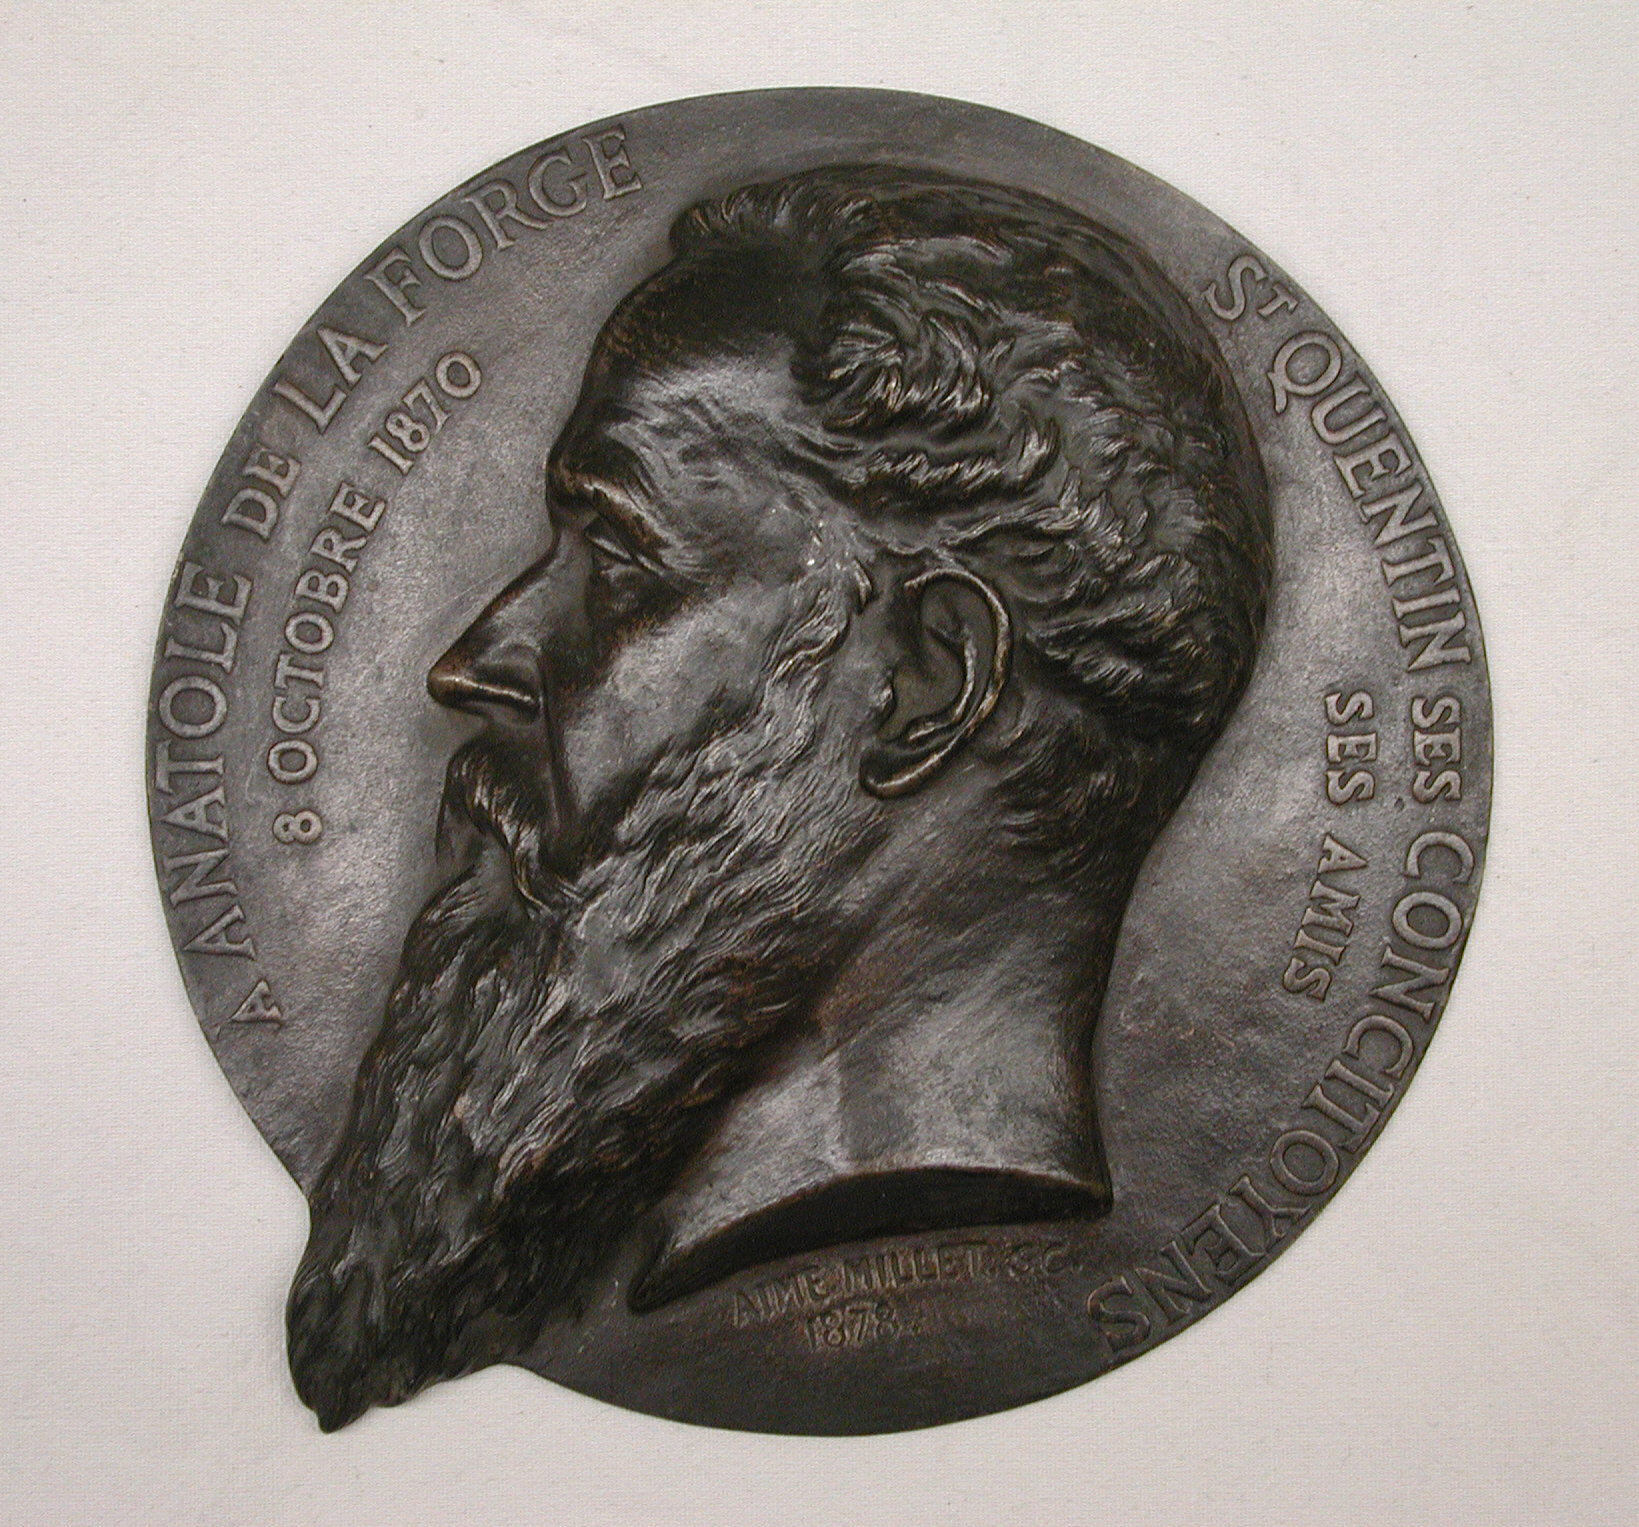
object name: medallion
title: Anatole de la Forge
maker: aimé millet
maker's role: maker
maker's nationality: french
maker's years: 1819-1891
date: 1878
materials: bronze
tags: men,profiles